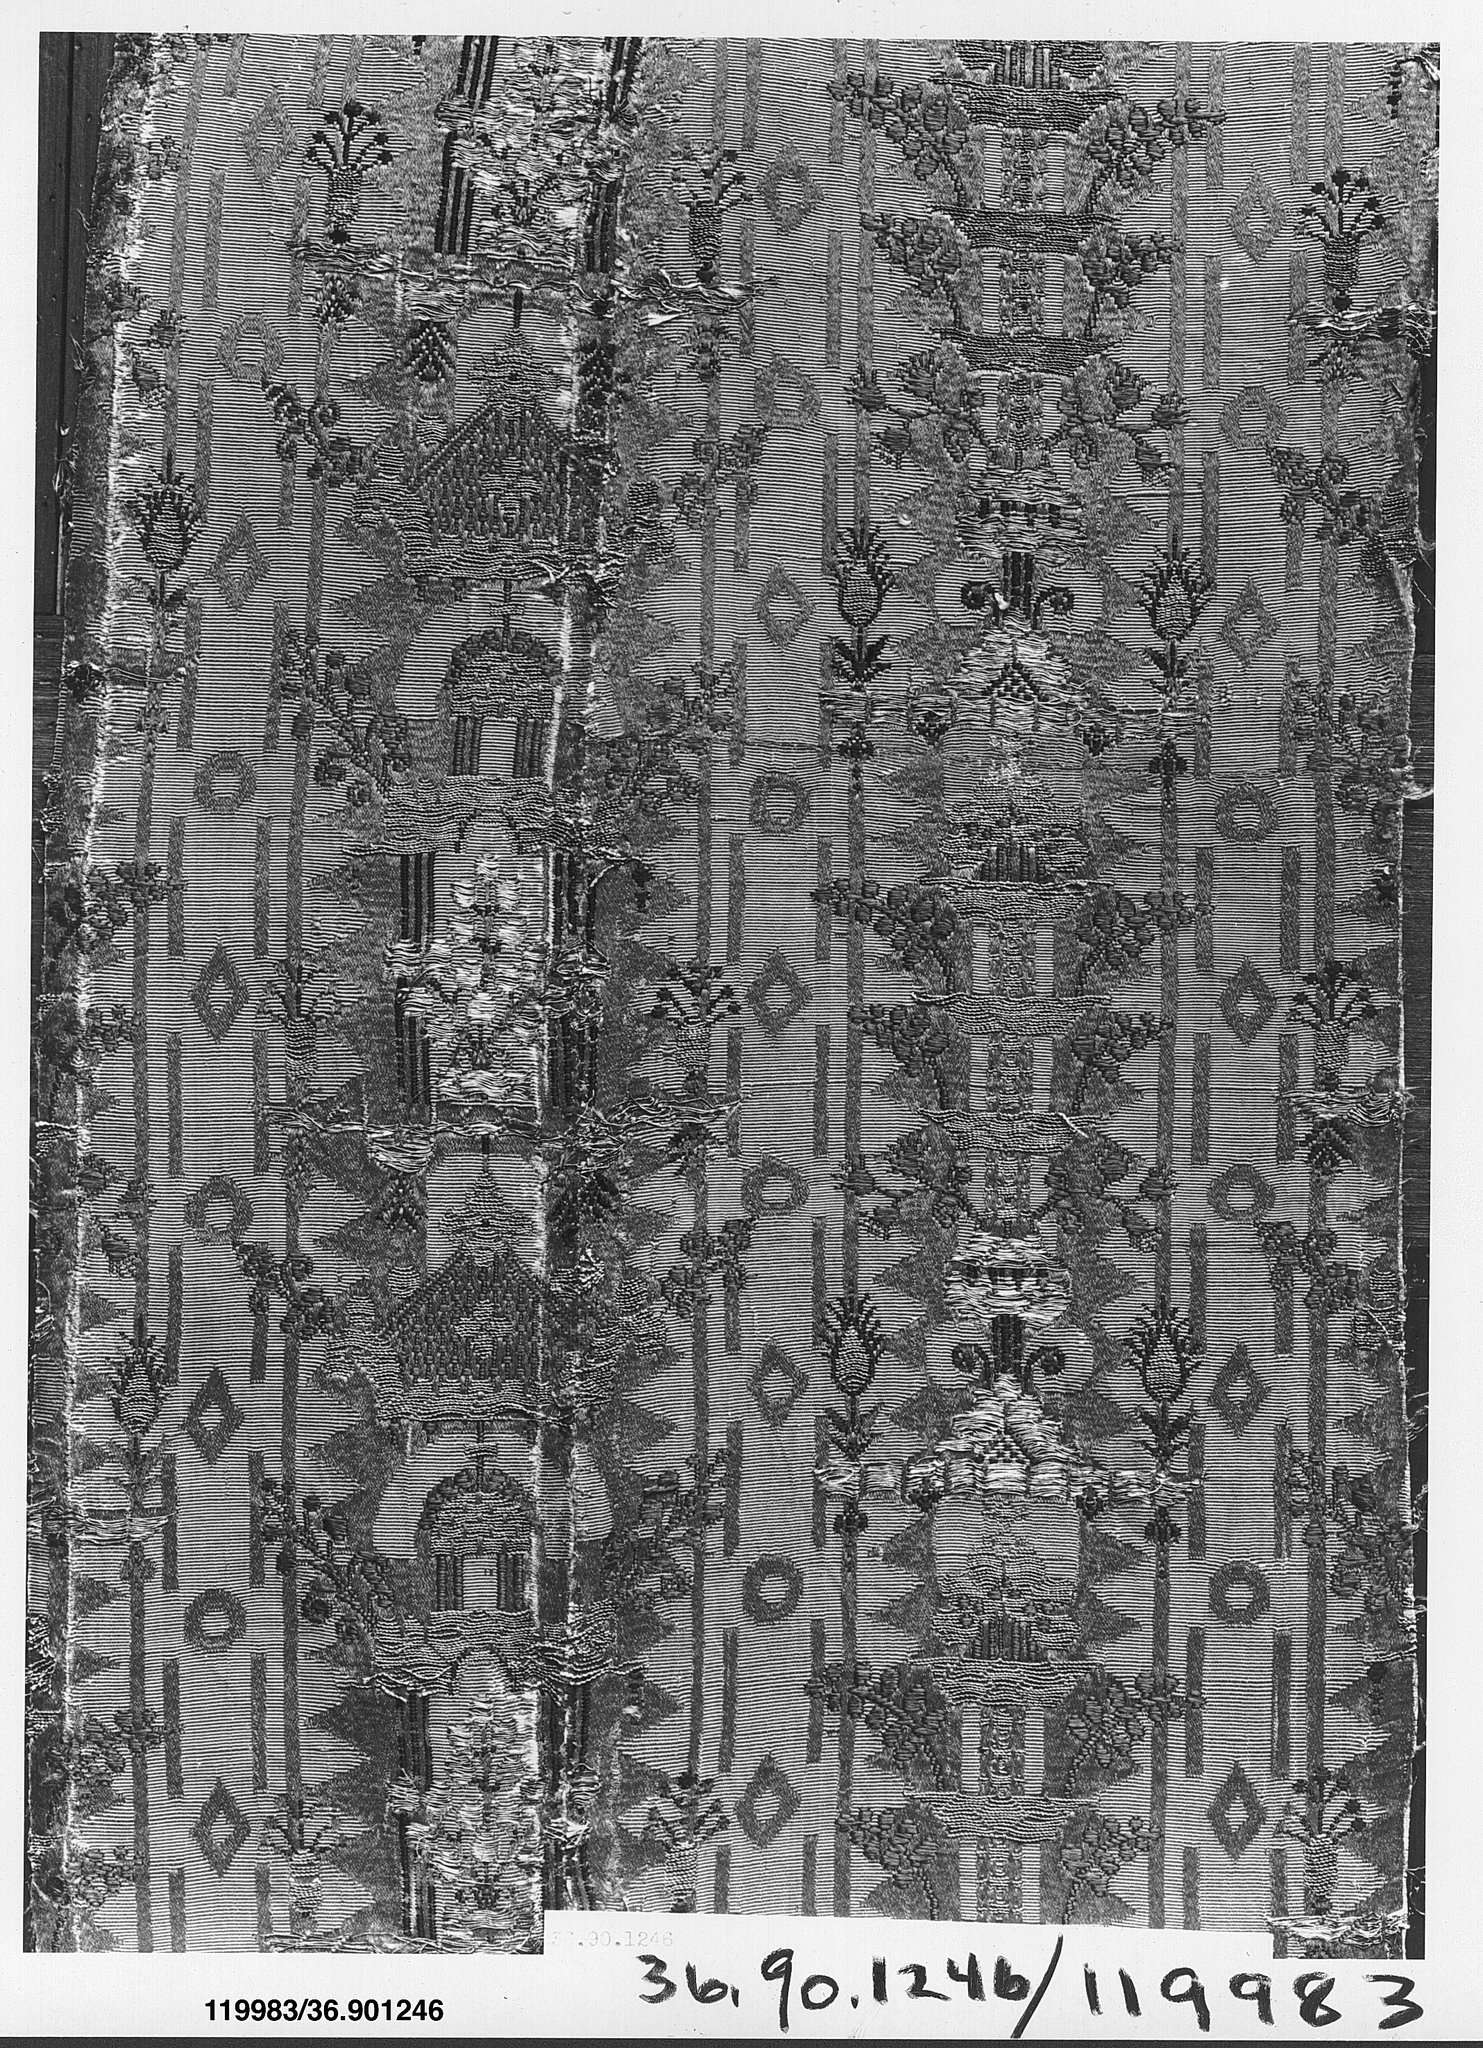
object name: piece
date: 1667-1733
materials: metal thread, silk